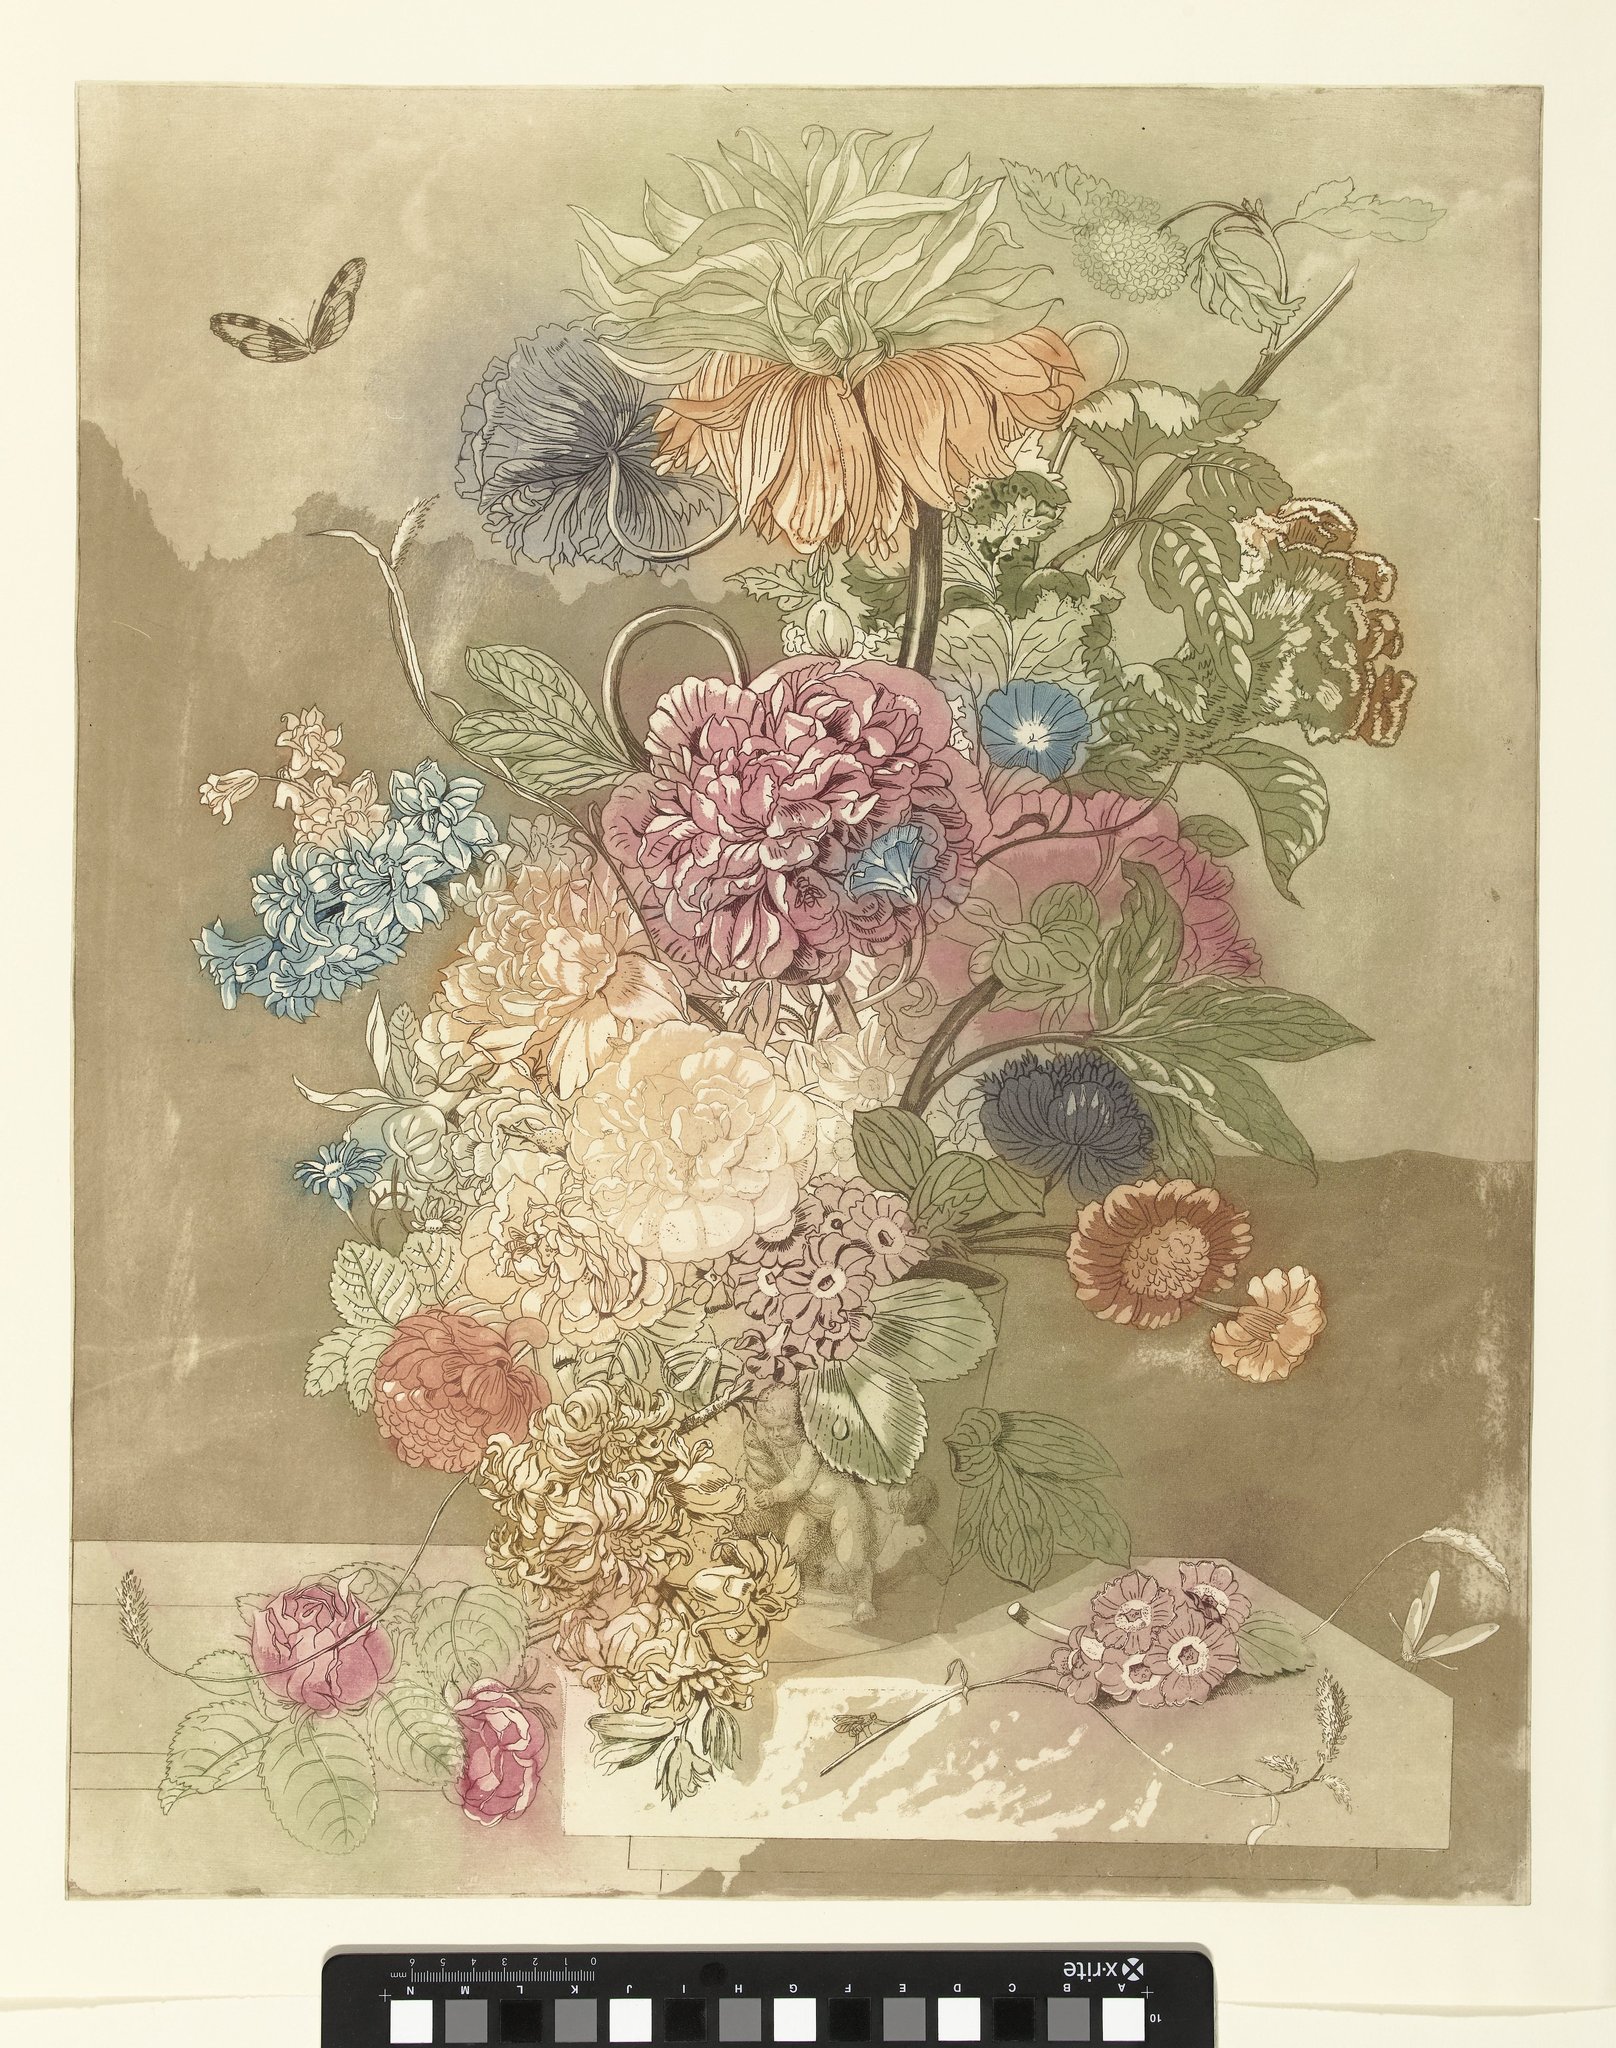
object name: print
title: Bloemstuk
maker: anthonie van den bos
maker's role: draughtsman, print maker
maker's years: 1763-1838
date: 1778-1838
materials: paper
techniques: aquatint, etching, lithography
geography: netherlands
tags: flowers in a vase